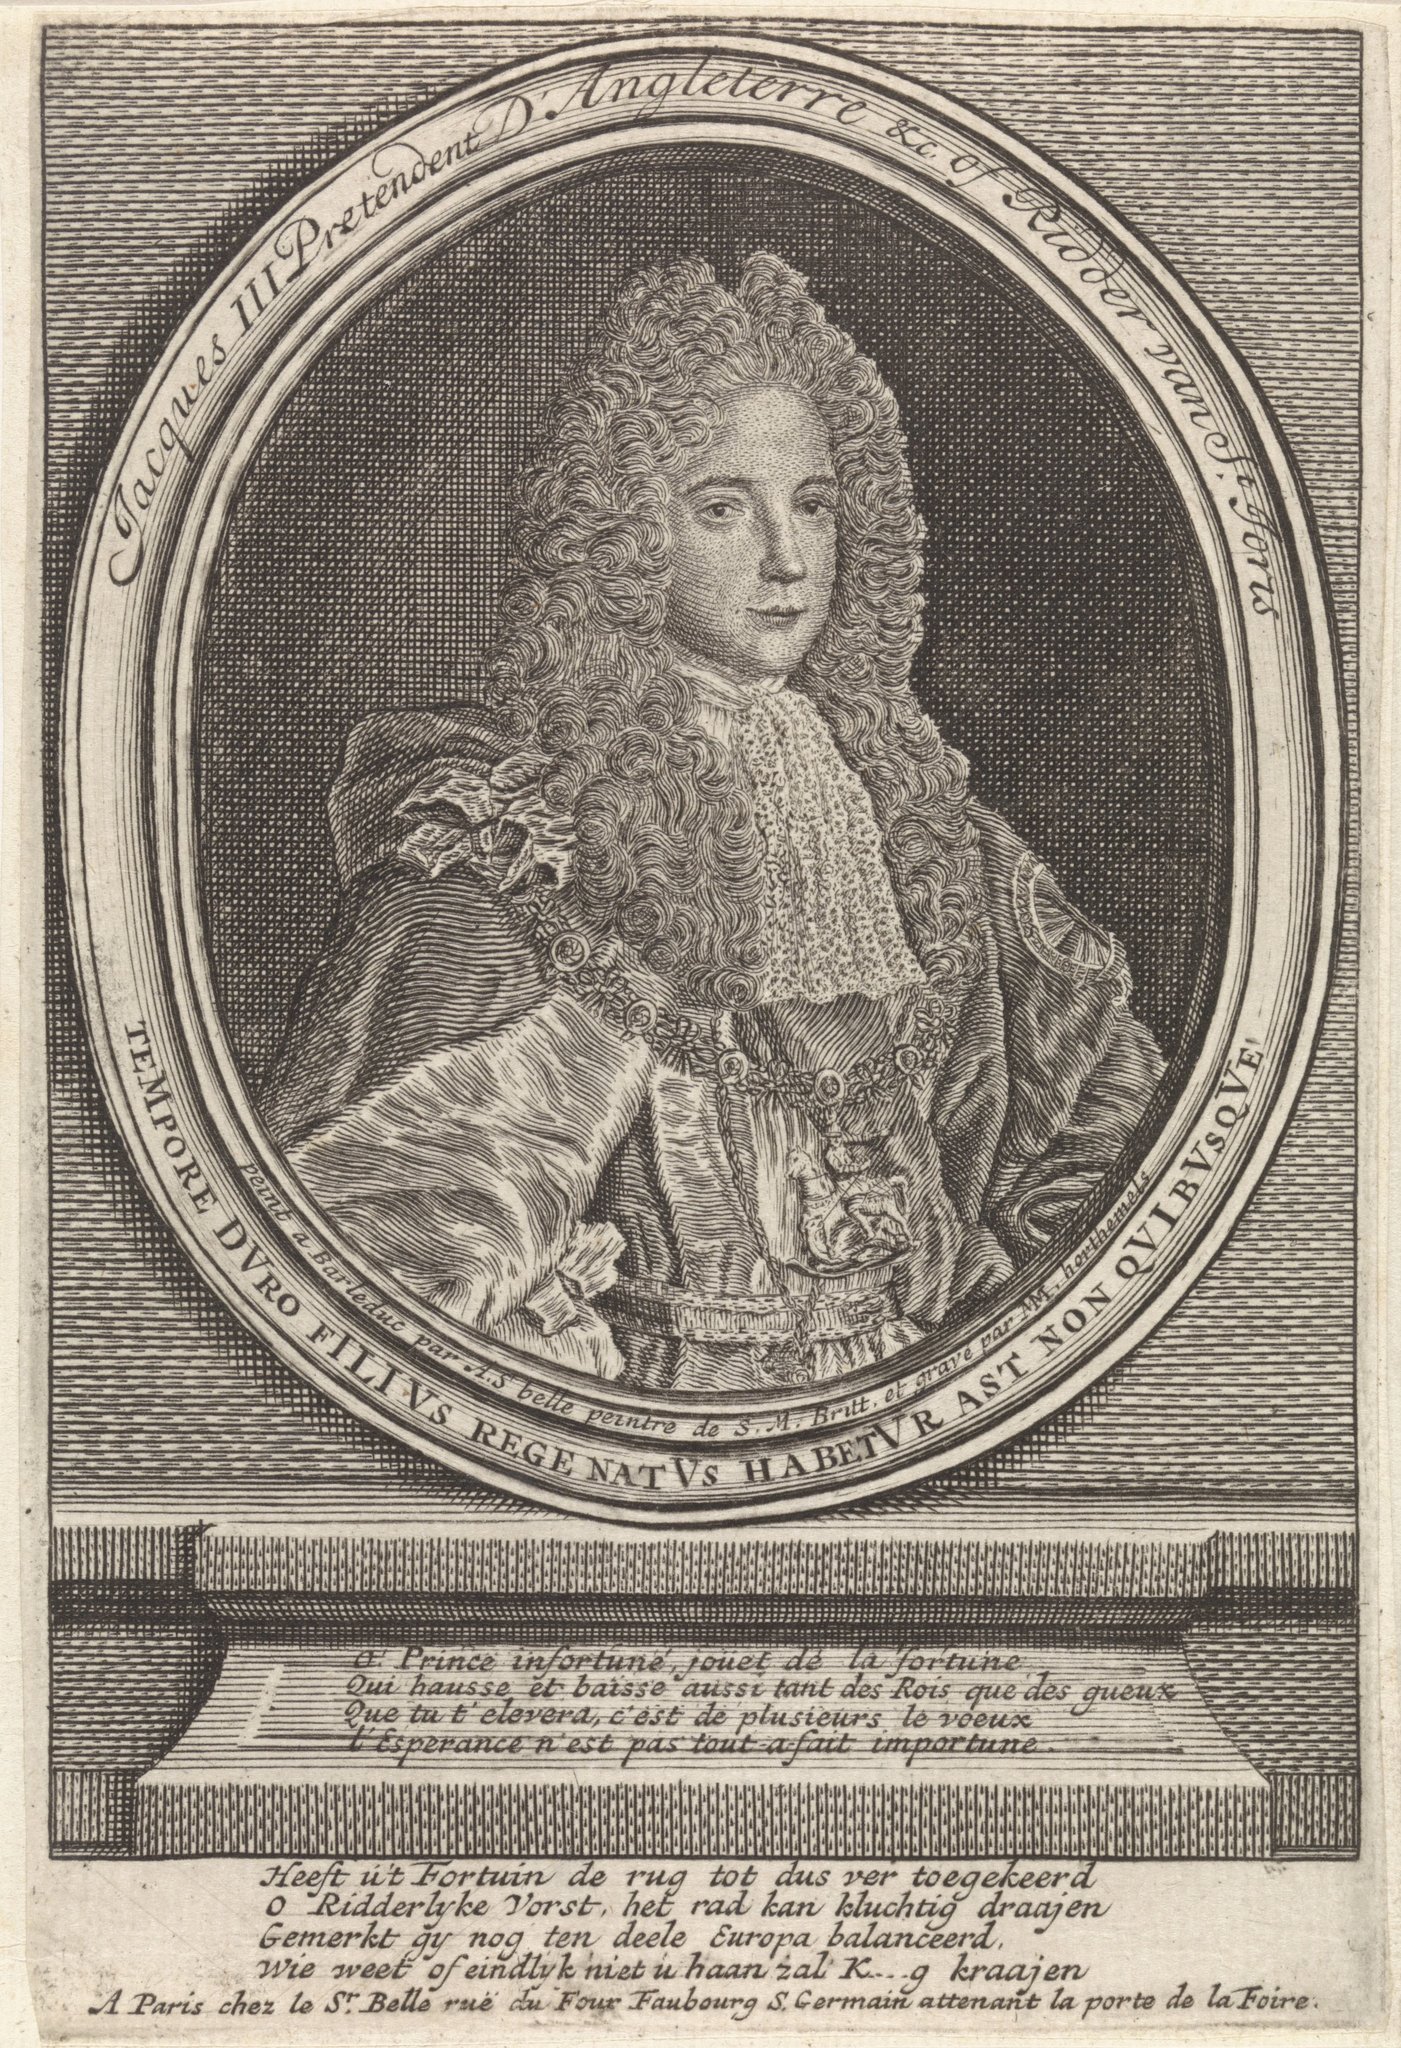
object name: print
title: Portret van de troonpretendent Jacobus III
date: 1696-1767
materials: paper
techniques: engraving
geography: paris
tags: london, rome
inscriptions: collector's mark: Lugt 2228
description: Ovaal portret van de pretendent Jacobus III (Jacobus Frans Eduard) in medaillon, ten halven lijve, naar rechts. Met randschrift in het Frans en Latijn. Onder het portret twee vierregelige verzen in het Frans en Nederlands.